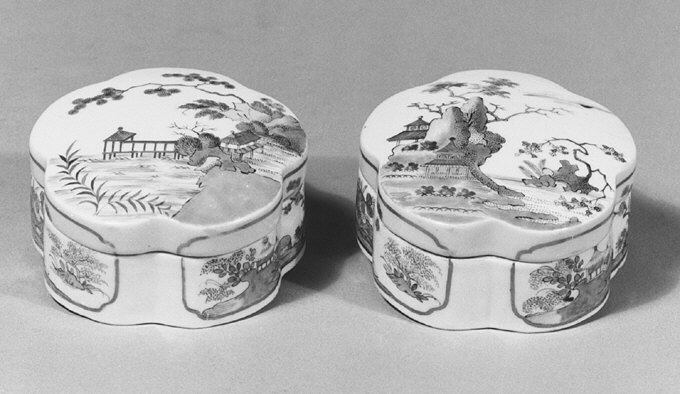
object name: box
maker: meissen manufactory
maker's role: manufactory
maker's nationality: german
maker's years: 1710-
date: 1730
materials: hard paste porcelain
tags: pagodas